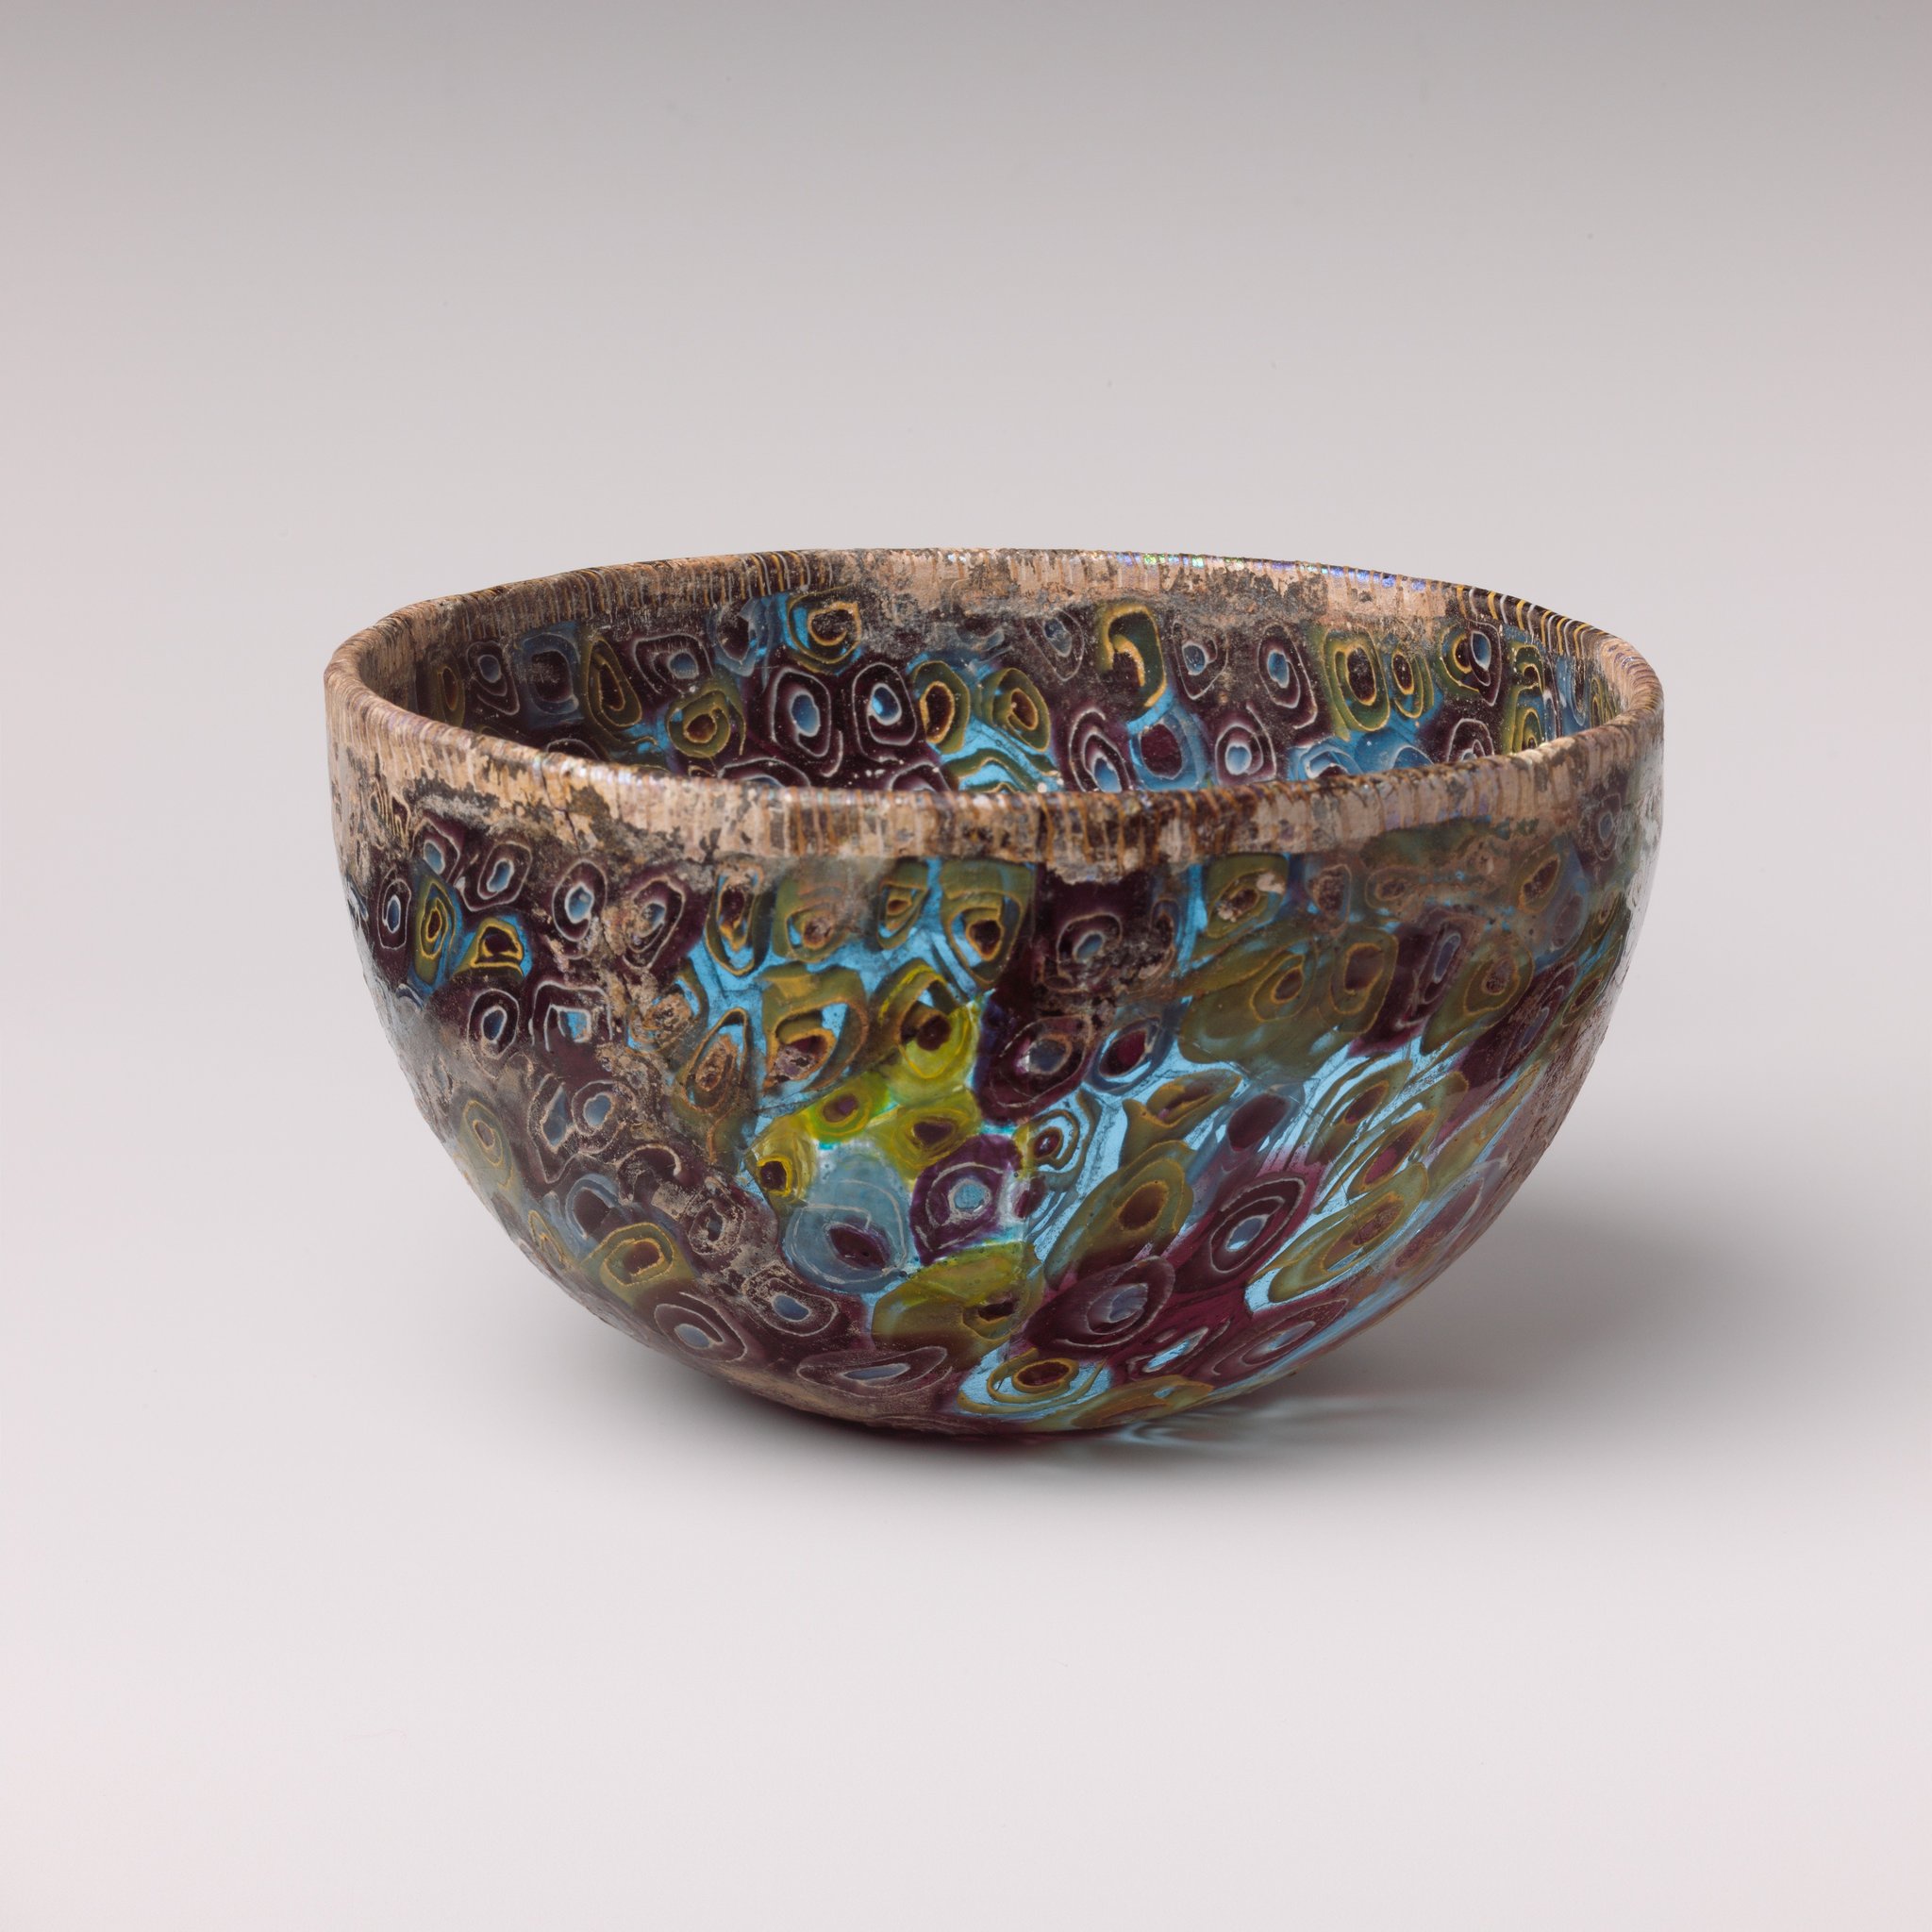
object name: bowl, mosaic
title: Glass hemispherical mosaic bowl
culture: greek, eastern mediterranean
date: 200-35 BCE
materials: glass